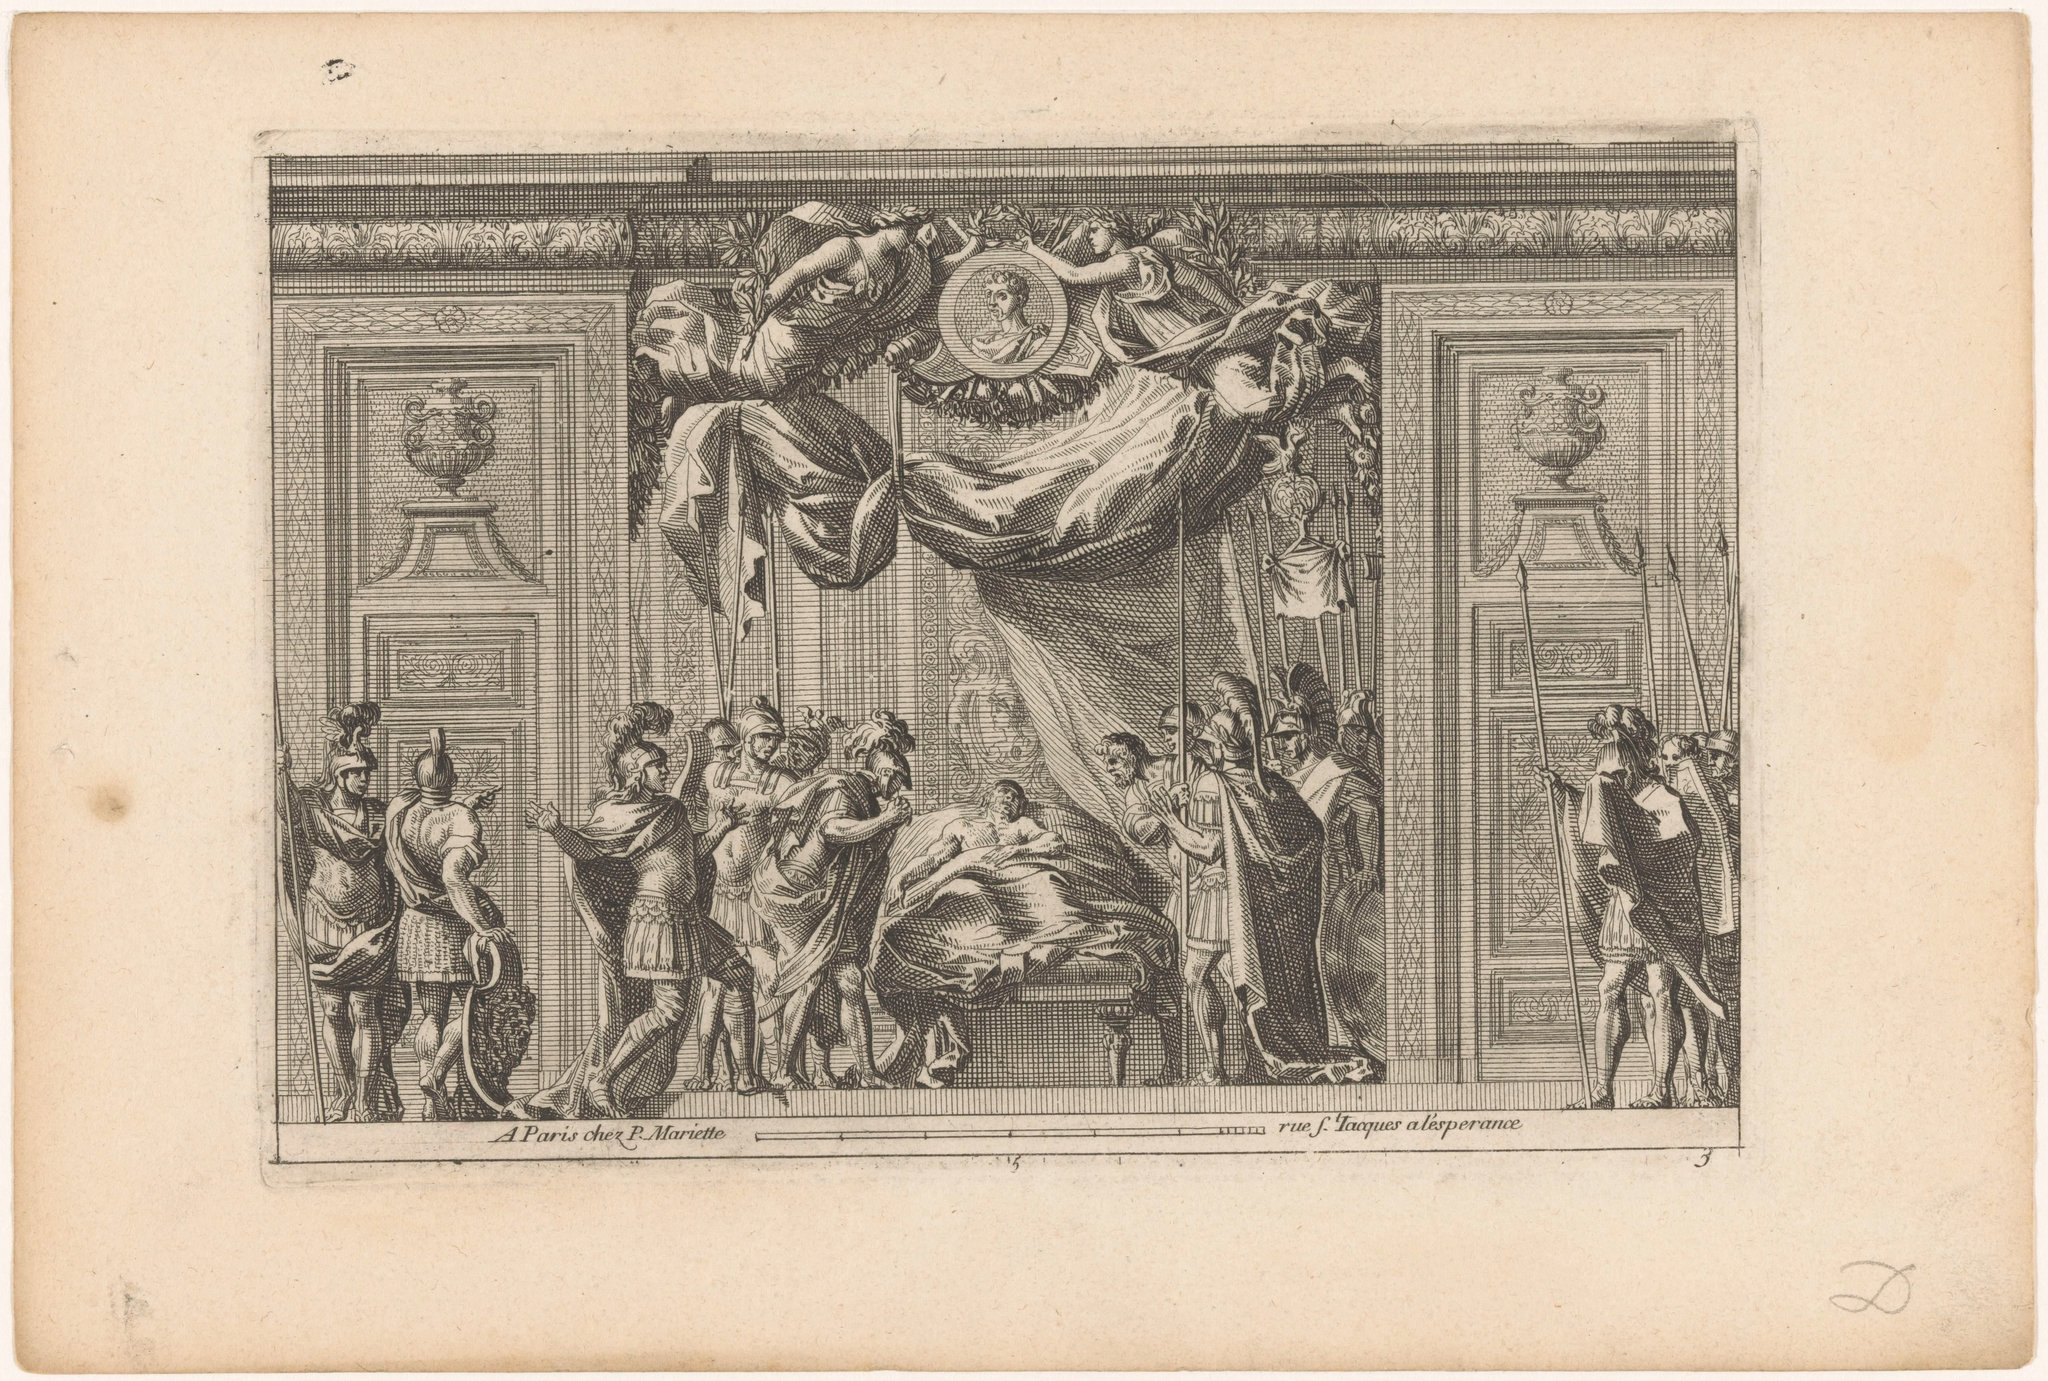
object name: print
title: Alkoof met stervende Germanicus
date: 1657-1716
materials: paper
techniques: etching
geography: paris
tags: death of germanicus caesar: he is lying on his deathbed, his wife agrippina grieving at his bedside, and his friends swearing to avenge his death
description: Alkoof met Germanicus liggend op een bed met daarboven draperieën en engelen met lauwerkrans. Rondom staan treurende soldaten. Rechts onder 3 genummerd.